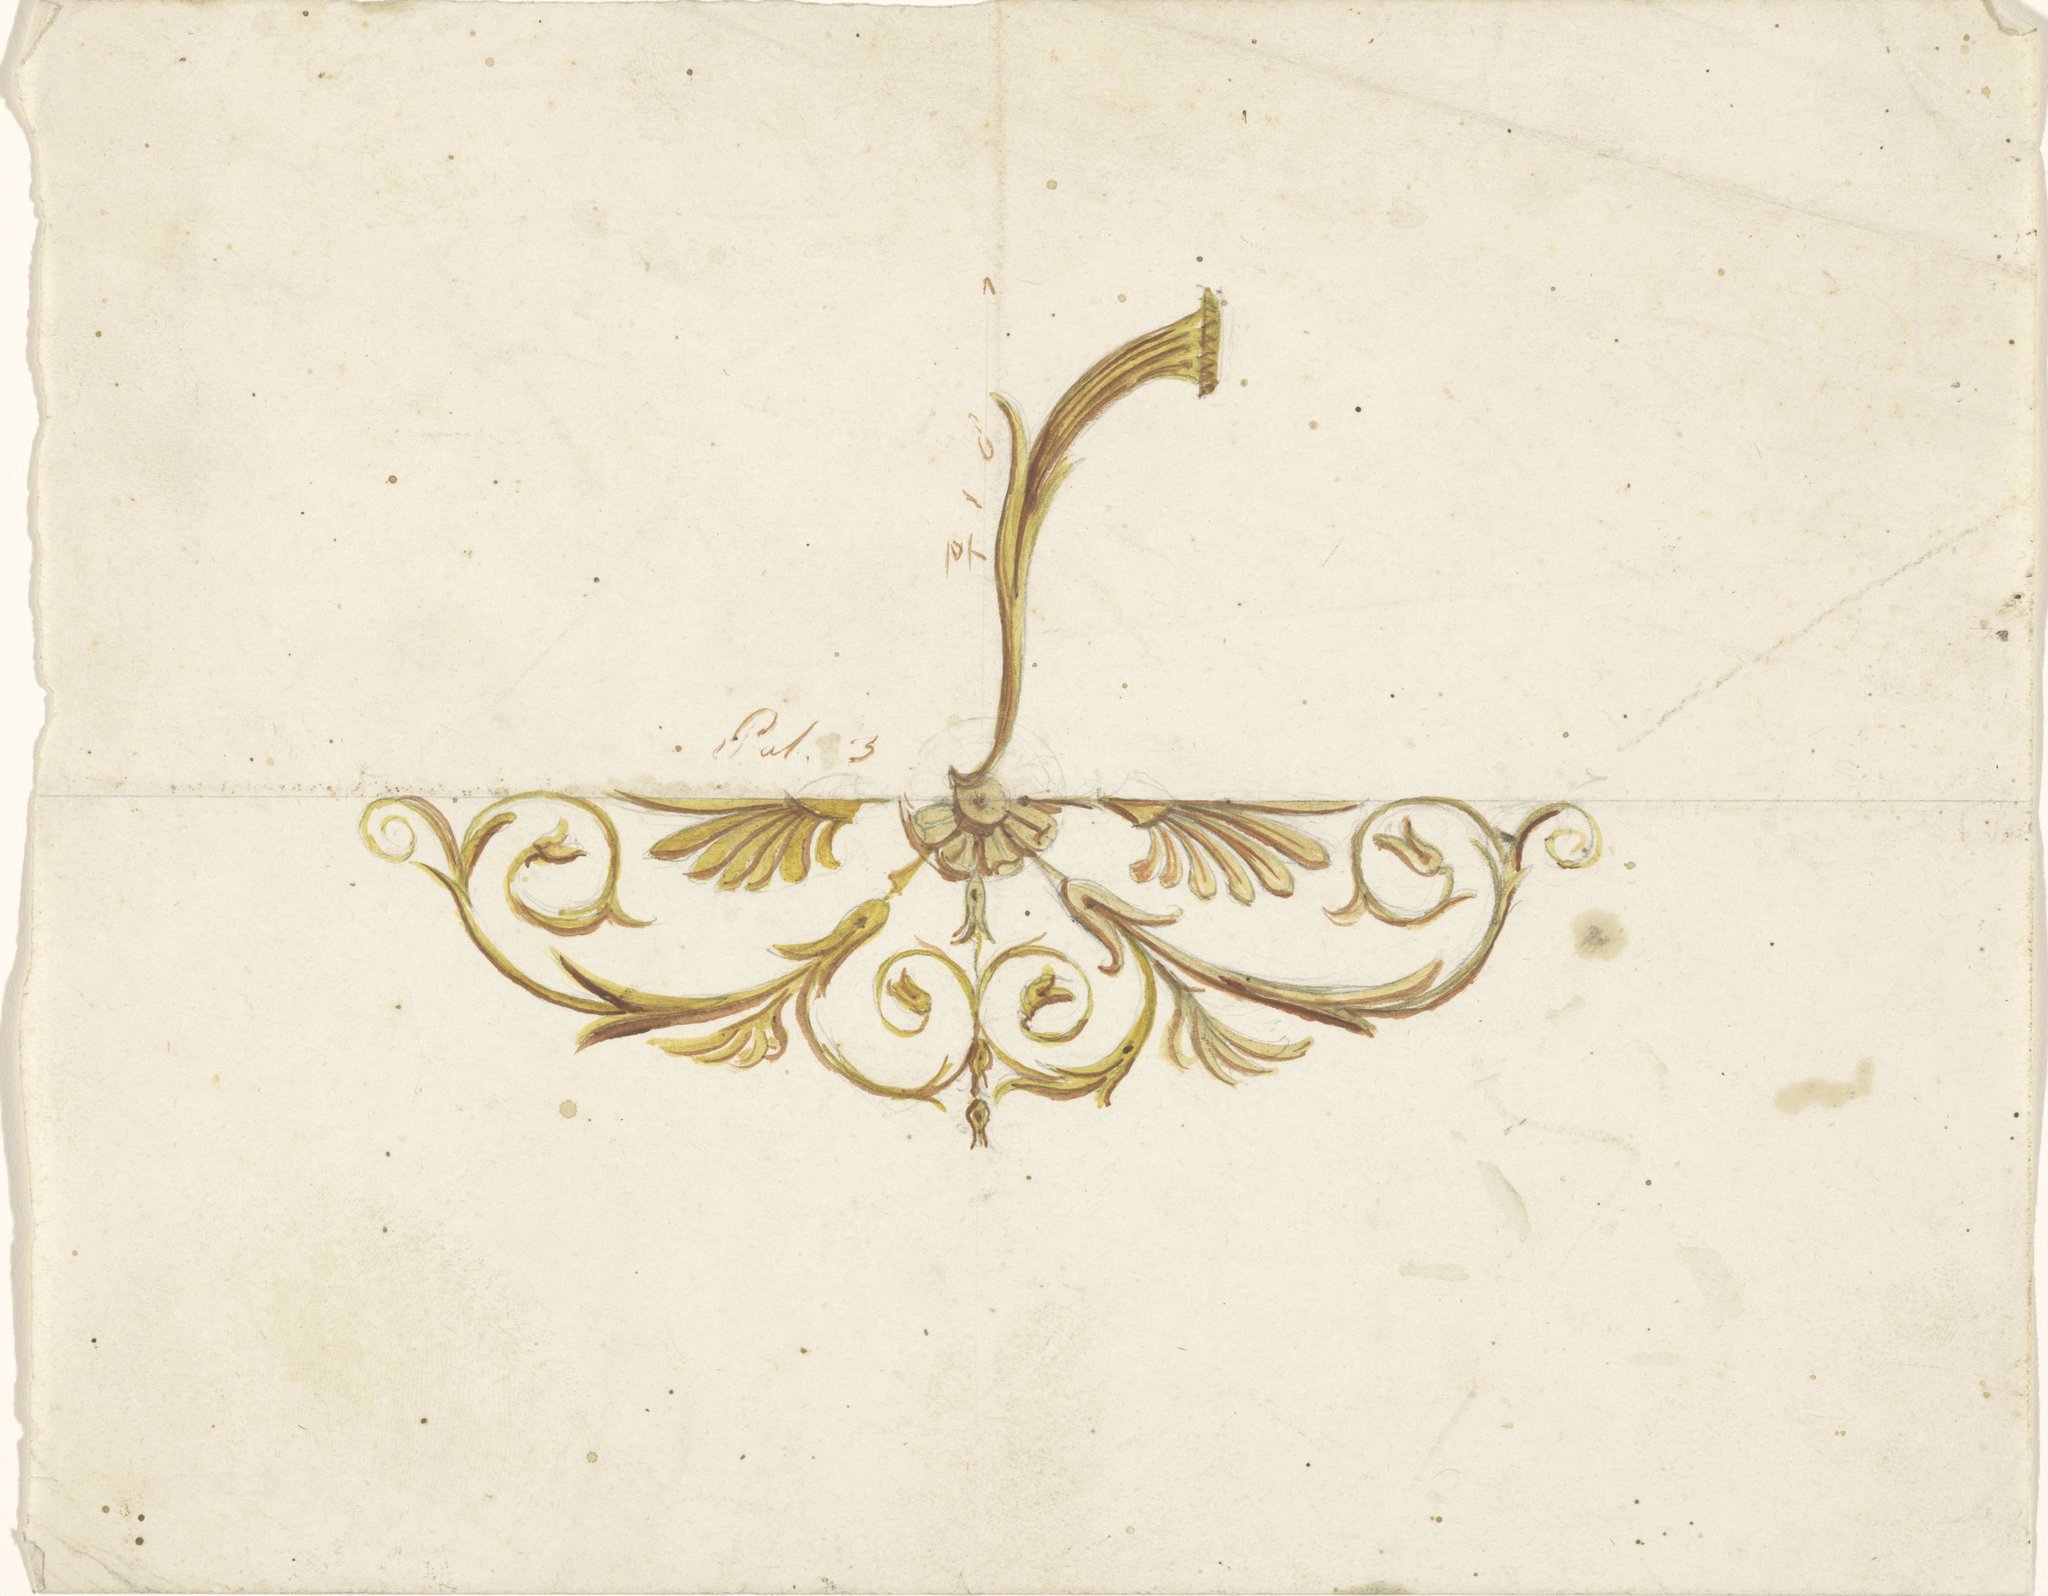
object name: design drawing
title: Ontwerp voor de achterplaat van een wandarm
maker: giuseppe valadier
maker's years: 1762-1839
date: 1800-1820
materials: graphite, paper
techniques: pen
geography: rome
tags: sconce, wall lamp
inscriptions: inscription: ‘Pal. 3 / P 1 ½’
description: Ontwerp voor de achterplaat (rechterhelft) en de arm van een wandarm.